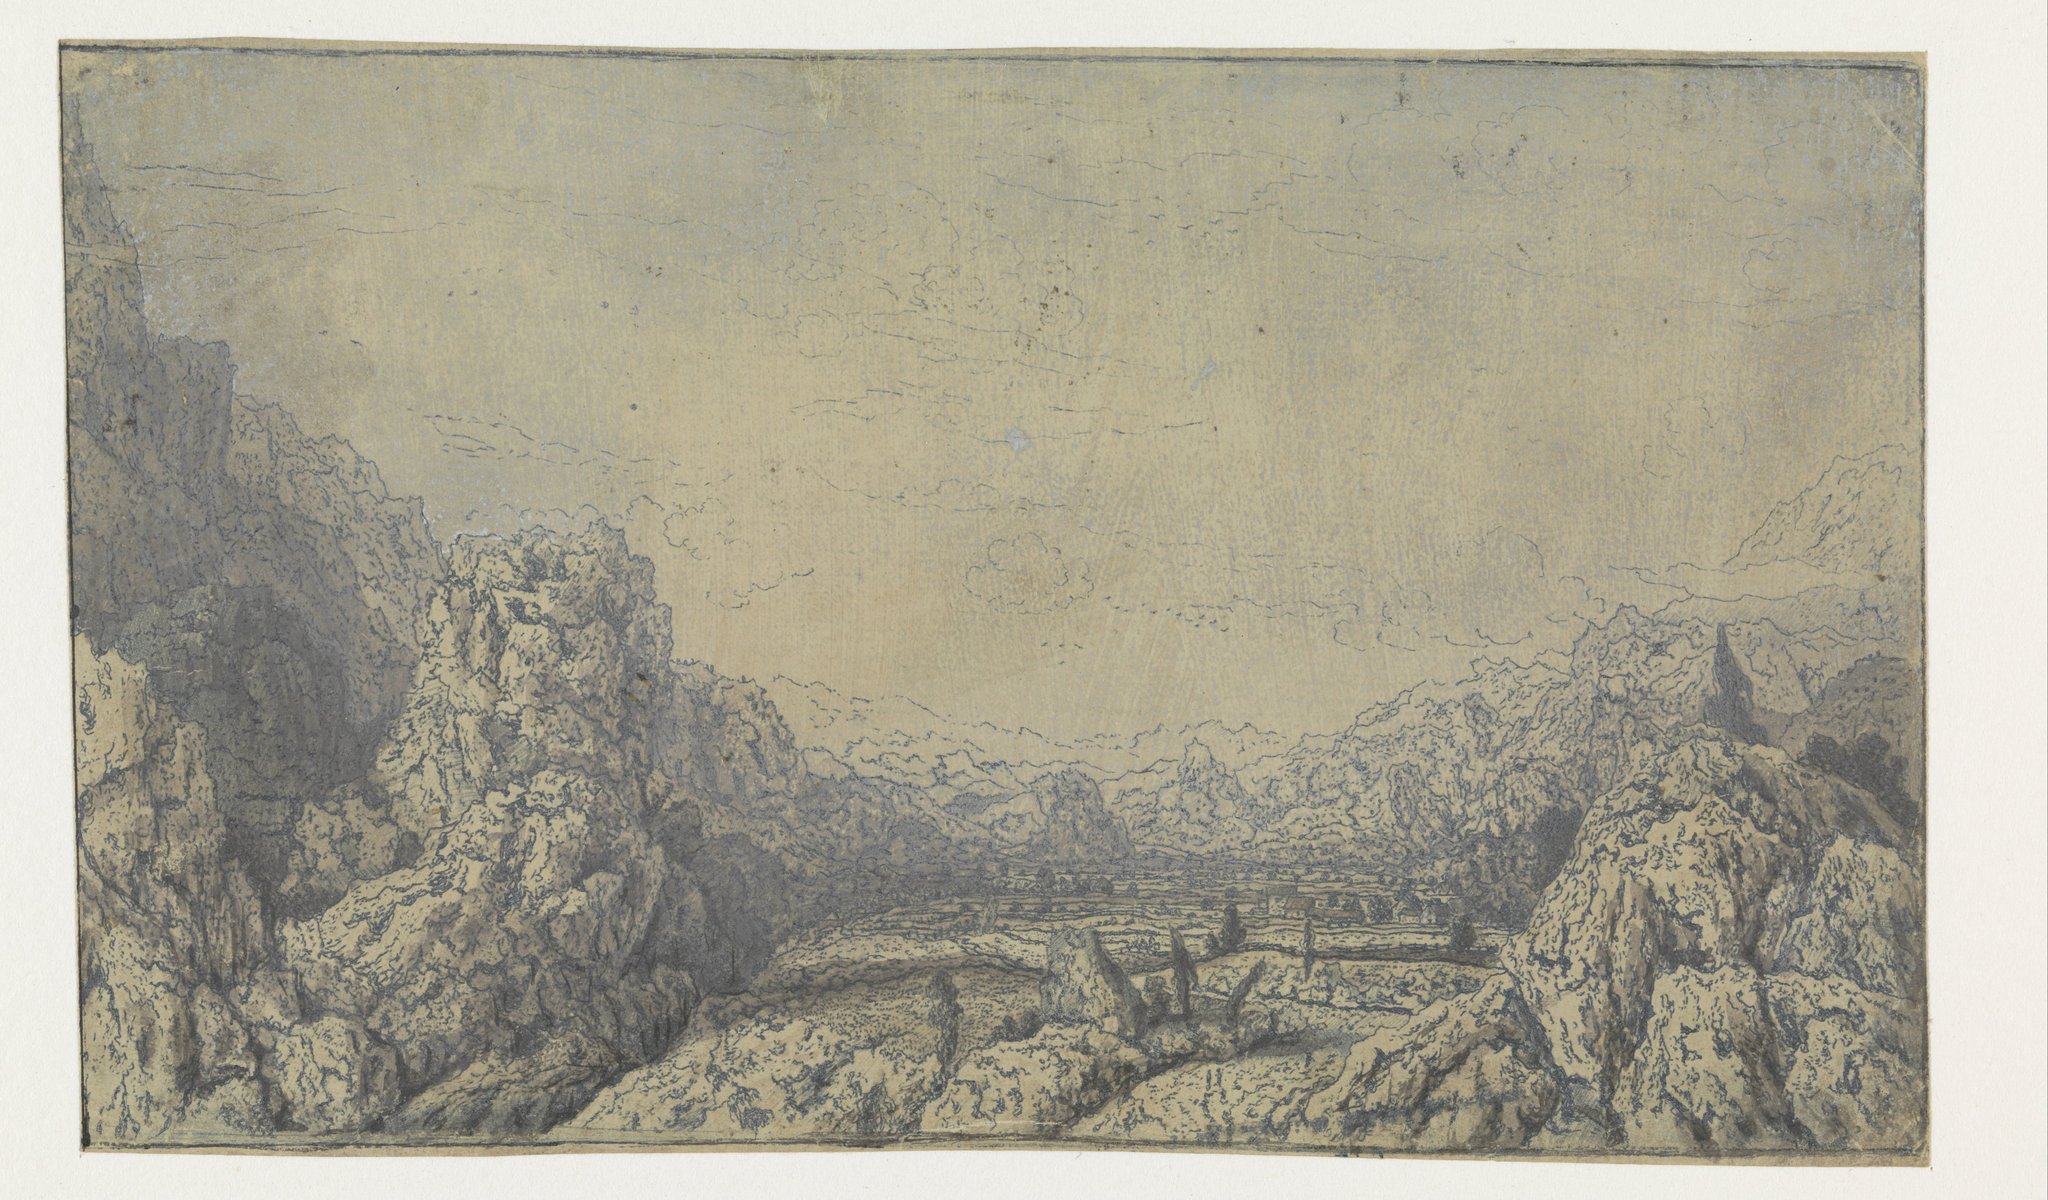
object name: print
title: The Enclosed Valley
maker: hercules segers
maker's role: draughtsman, painter, print maker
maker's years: 1589-1640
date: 1625-1630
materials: paint, paper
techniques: brush, drypoint, etching, hand coloring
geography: amsterdam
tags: dale, valley